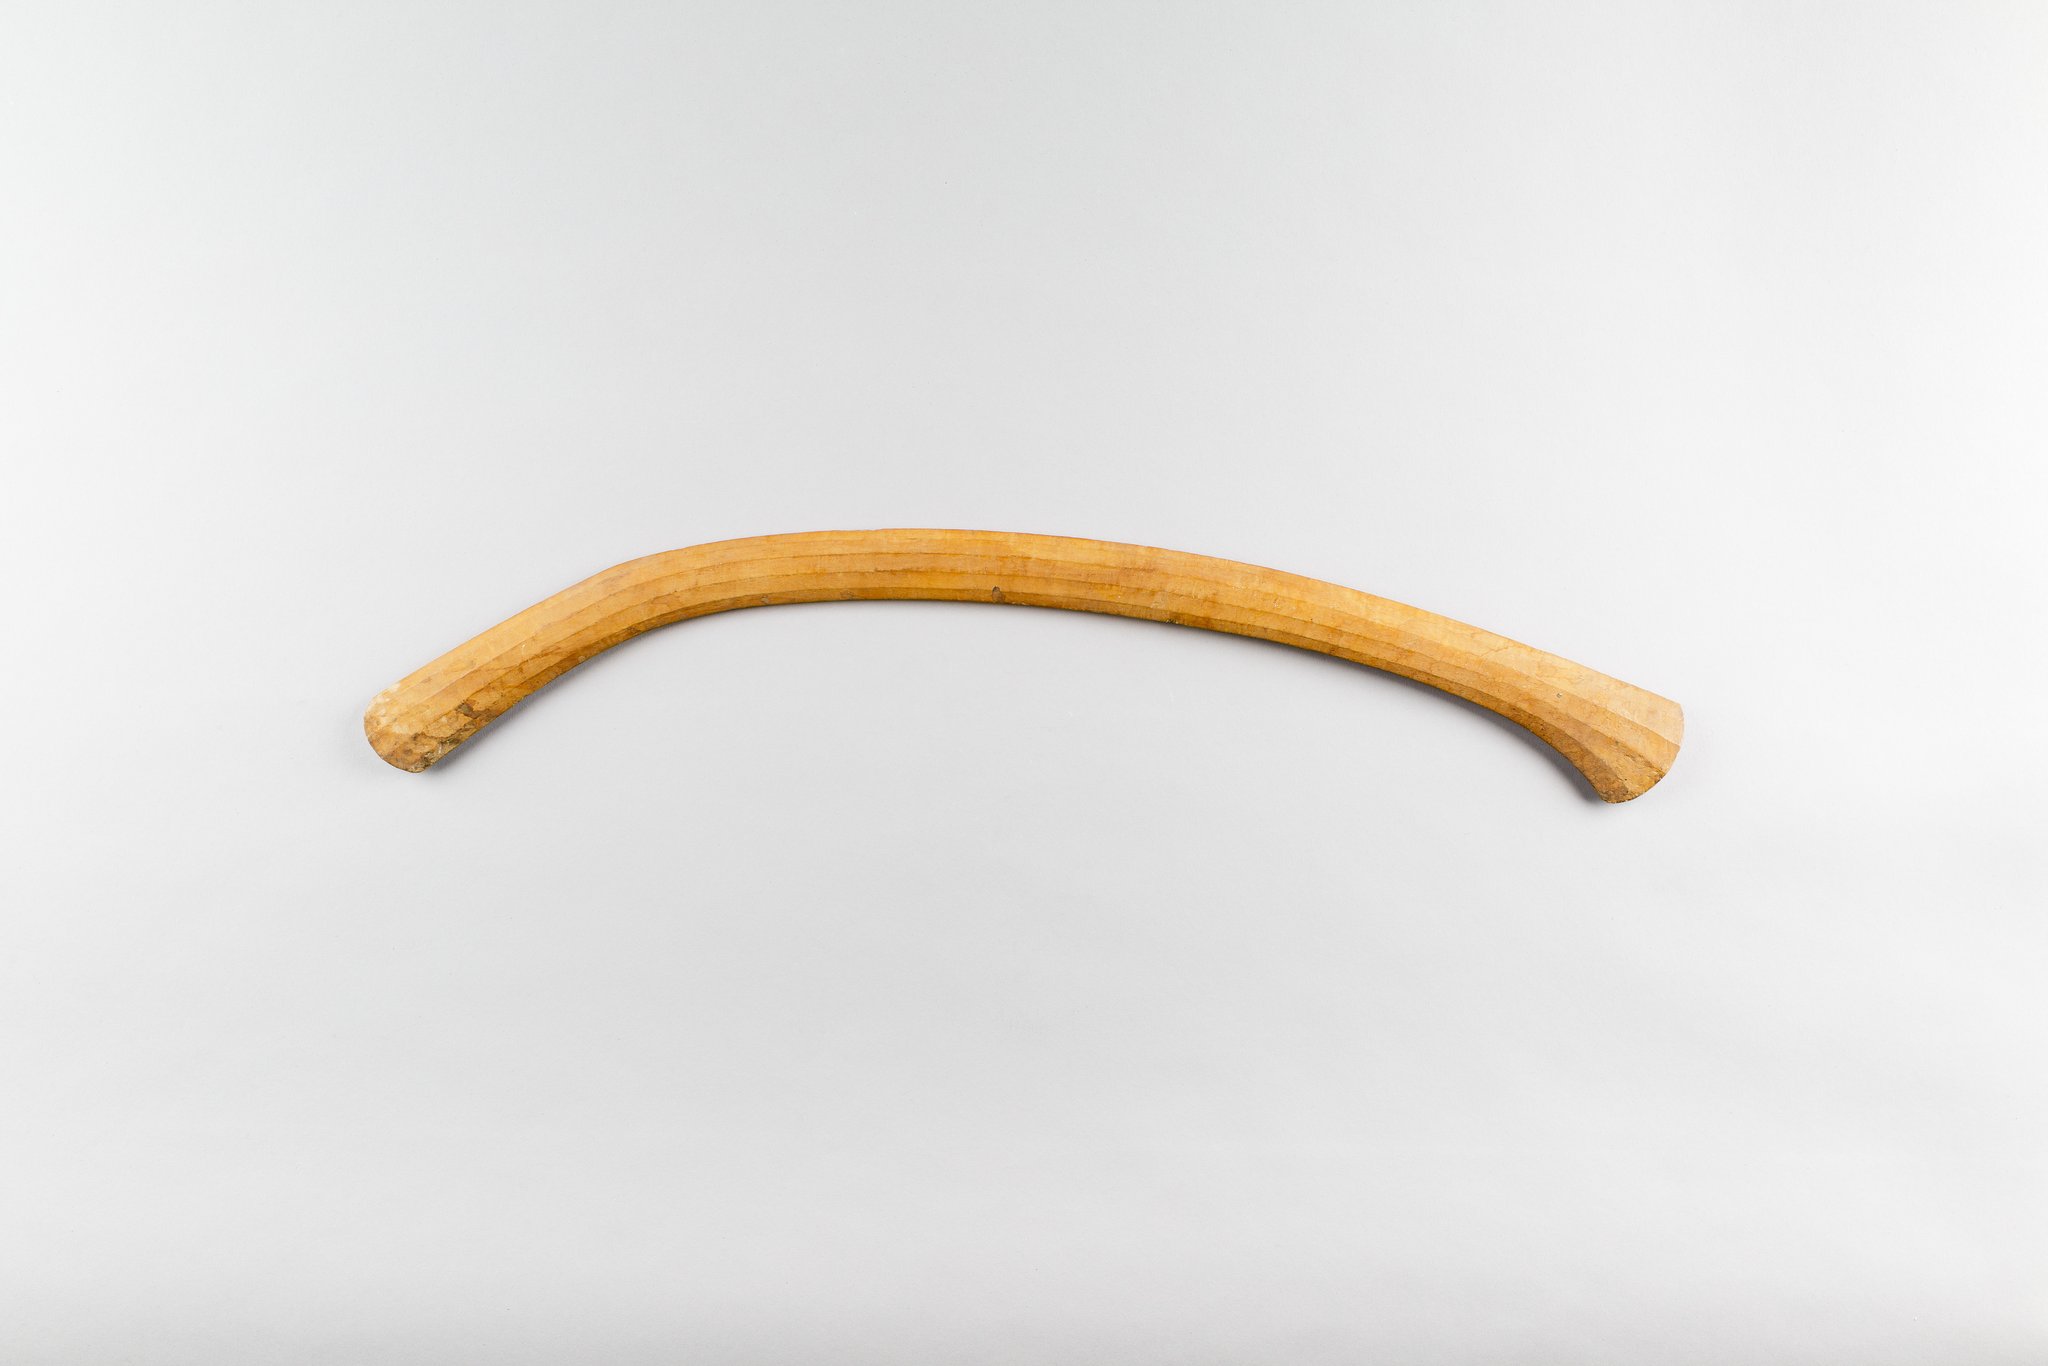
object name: throw stick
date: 1479-1458 BCE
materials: wood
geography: egypt